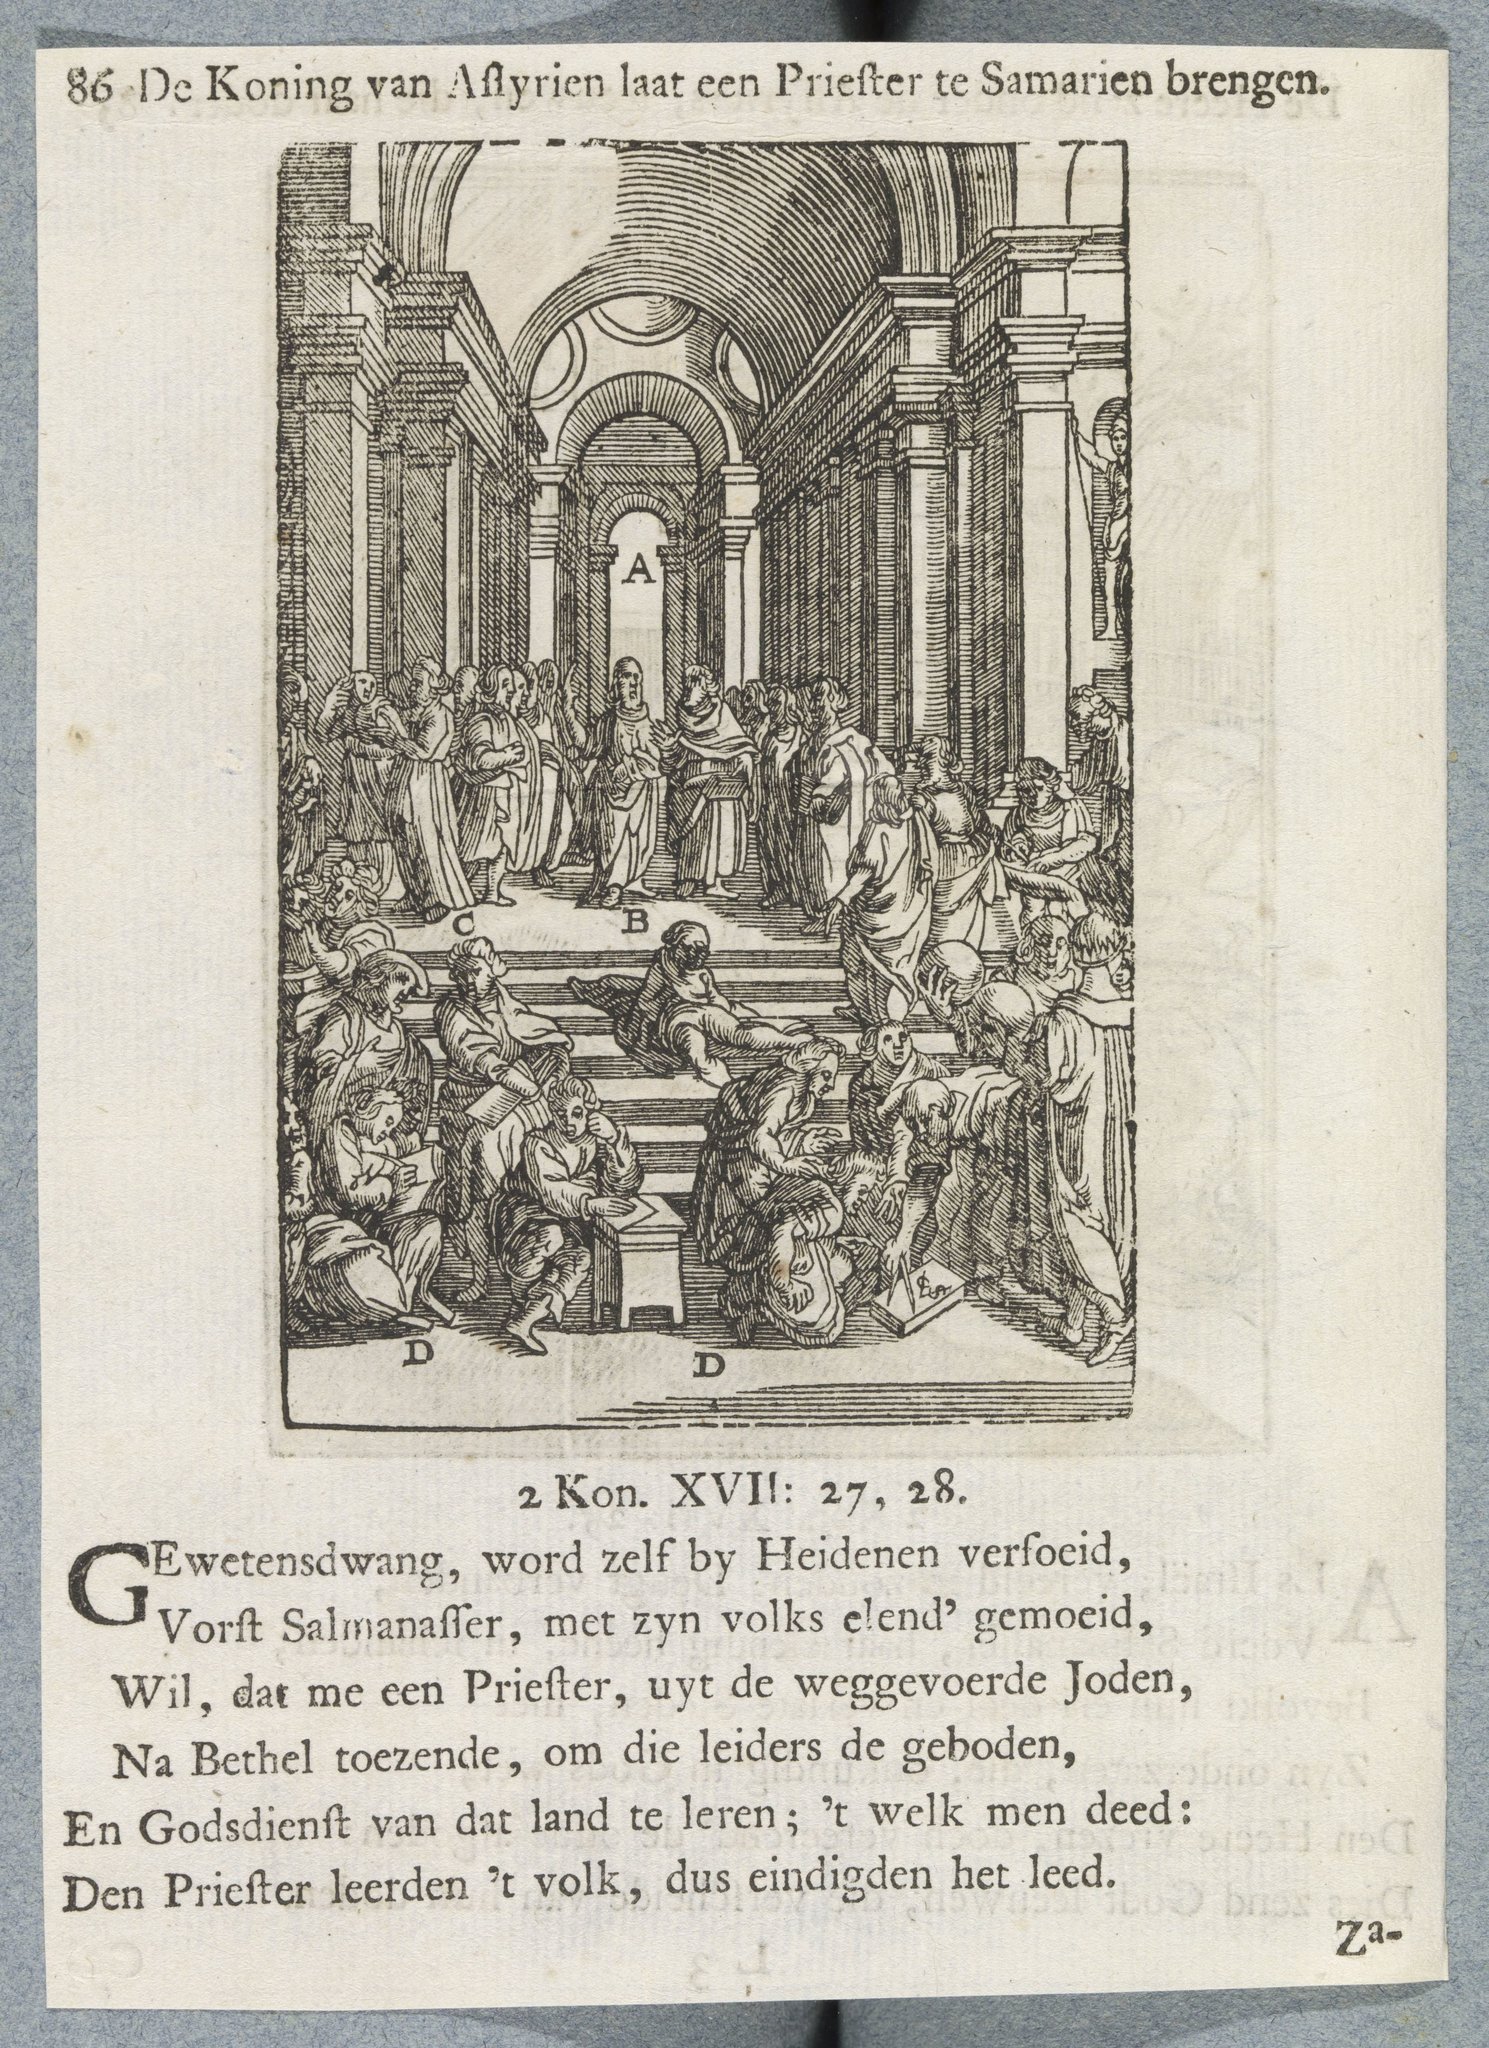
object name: album leaf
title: Priester in Samaria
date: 1629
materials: paper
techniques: letterpress printing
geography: amsterdam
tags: scholar, philosopher, an israelite priest, deported to assyria, is sent back to bethel where he teaches the people how to worship god, paul in athens: on the areopagus he discusses with philosophers (in front of the temple of mars)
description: De prent is afkomstig uit: Bybels Lusthof. Amsterdam, J. Klooster, 1740. Ze werd eerder gebruikt, als afbeelding van Paulus in Athene, in: Der Zielen Lust-hof. Leuven, I.Jacbosz voor P.J. Paets [= Amsterdam, P.J. Paets], 1629. De voorstelling gaat terug op het fresco 'De School van Athene' door Rafaël in de Stanza della Segnatura in het Apostolisch paleis in het Vaticaan.